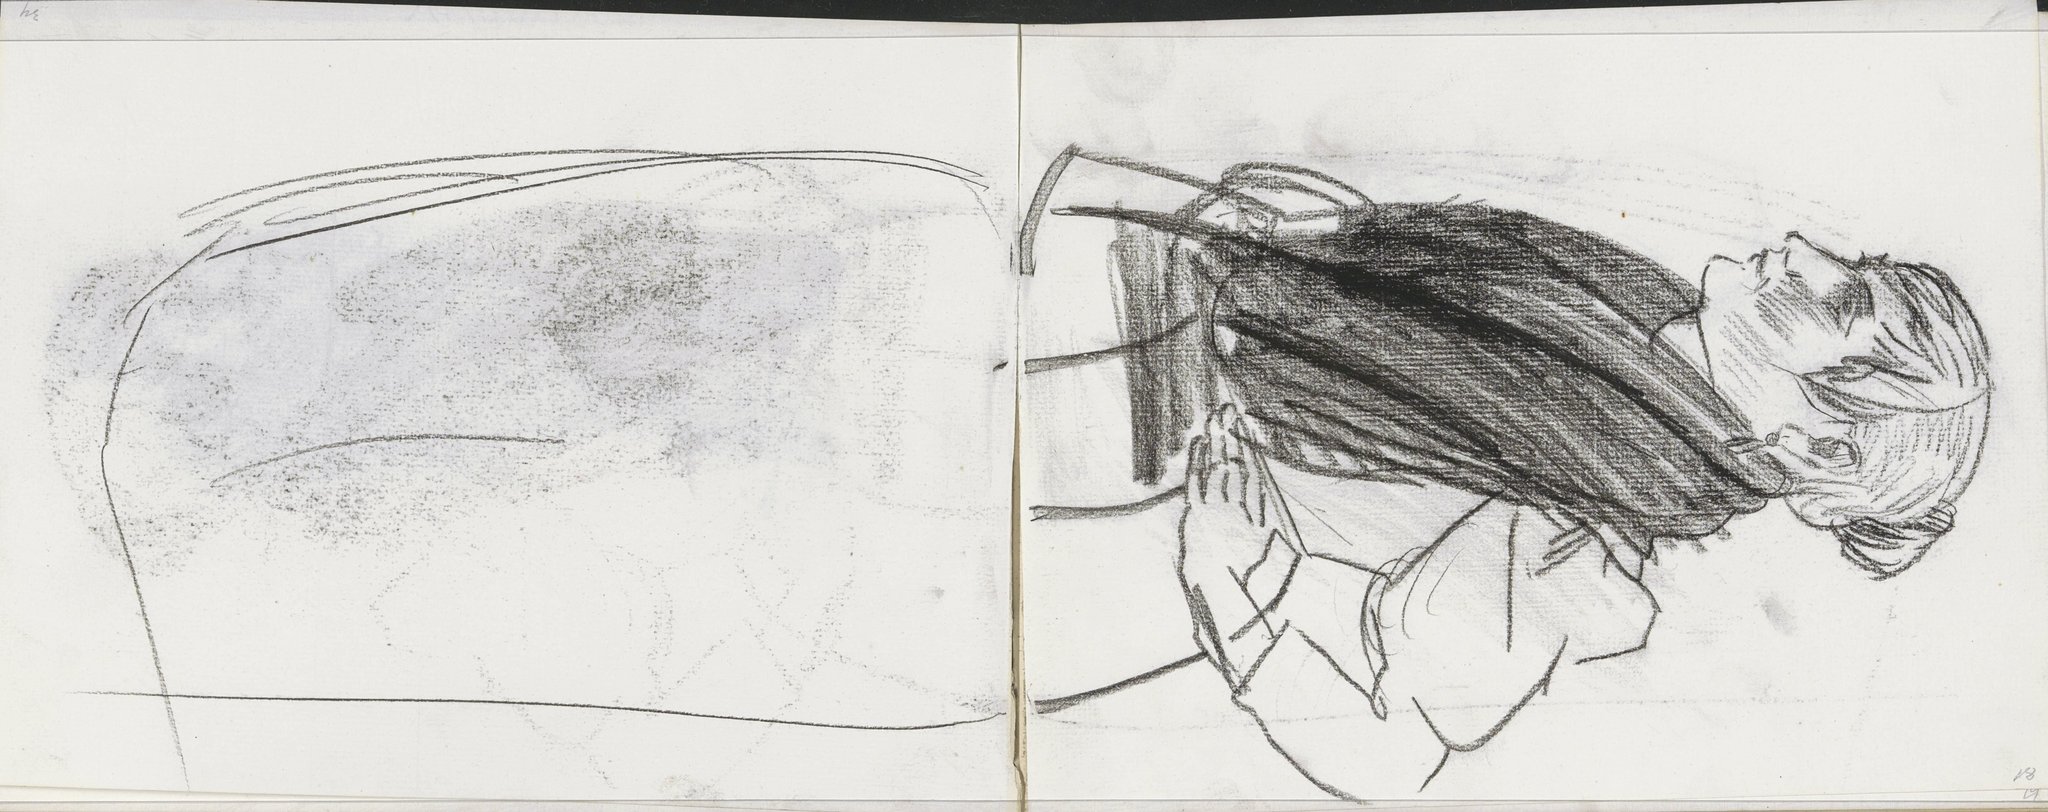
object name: sketchbook leaf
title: Staande vrouw met oorbel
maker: isaac israels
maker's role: draughtsman, painter, print maker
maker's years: 1865-1934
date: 1875-1934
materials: chalk, paper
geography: amsterdam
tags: adult man (+ standing), ear-rings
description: Haar linkerhand heeft ze in haar zij. Blad 17 verso en blad 18 recto uit schetsboek XX met 26 bladen.